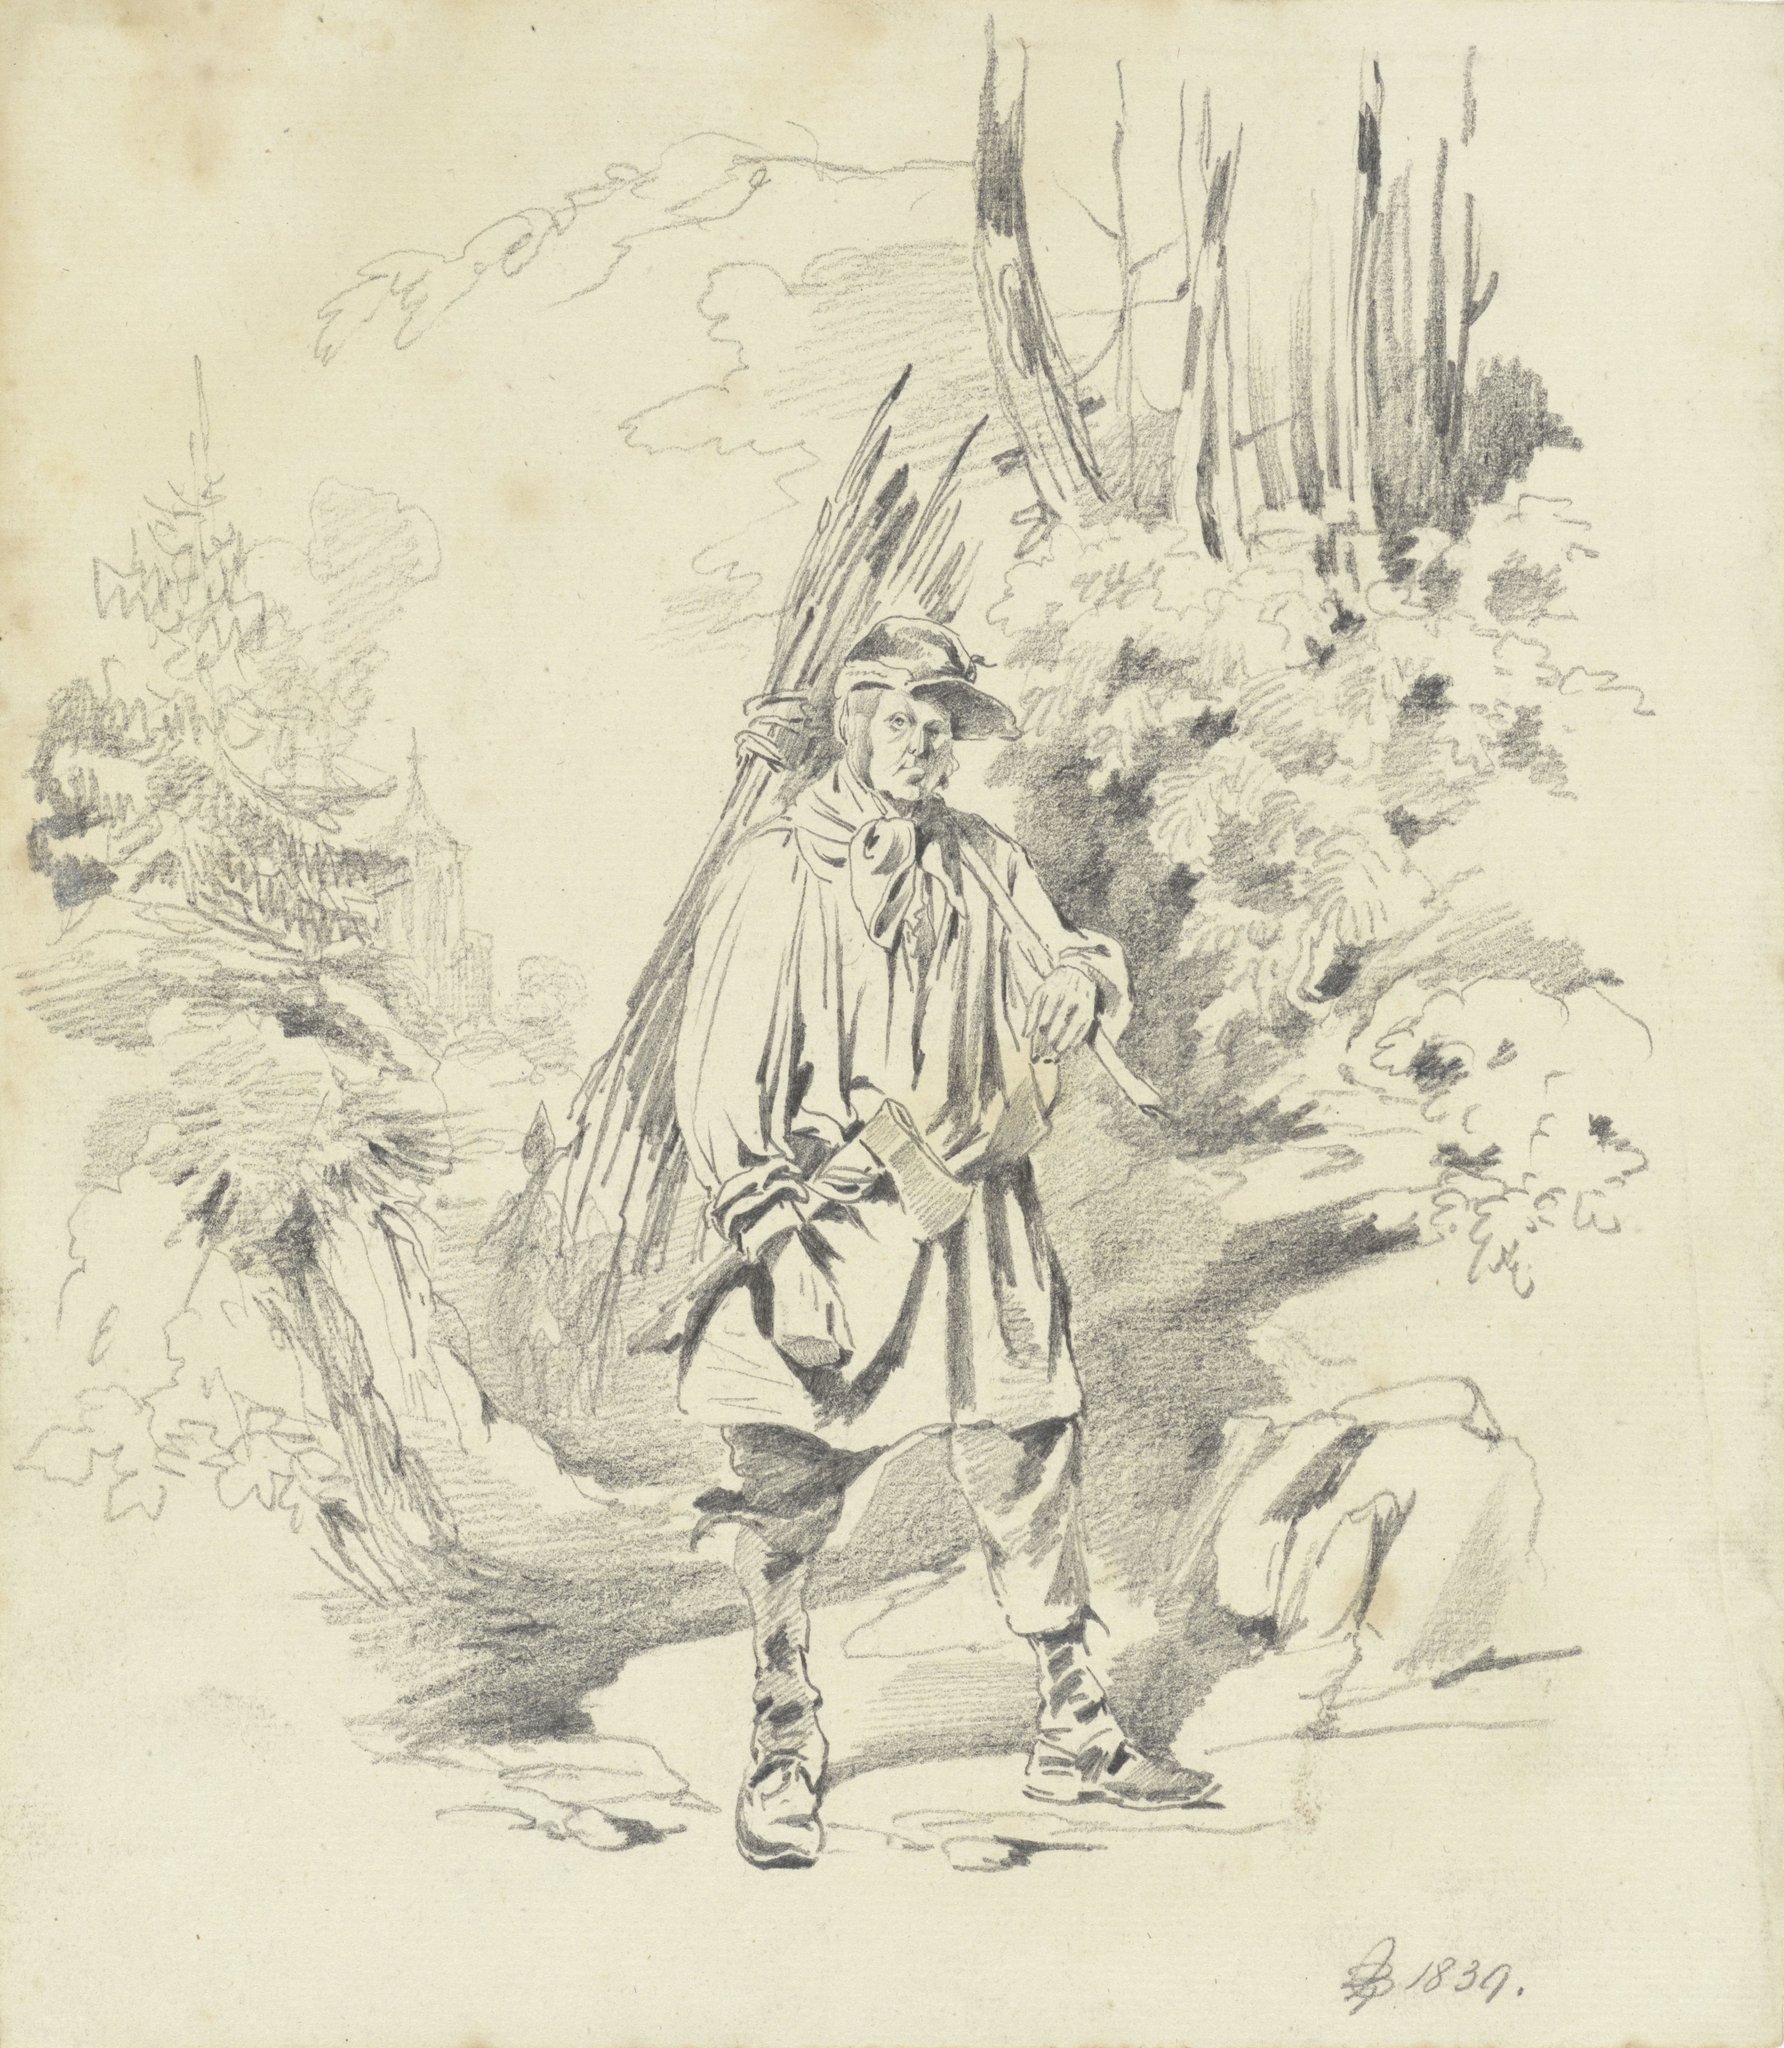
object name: drawing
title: Houtsprokkelaar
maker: pieter van loon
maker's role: draughtsman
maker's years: 1801-1873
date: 1839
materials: paper, pencil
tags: woodcutting, woodcutter ~ forestry, folk costume, regional costume, arnhem